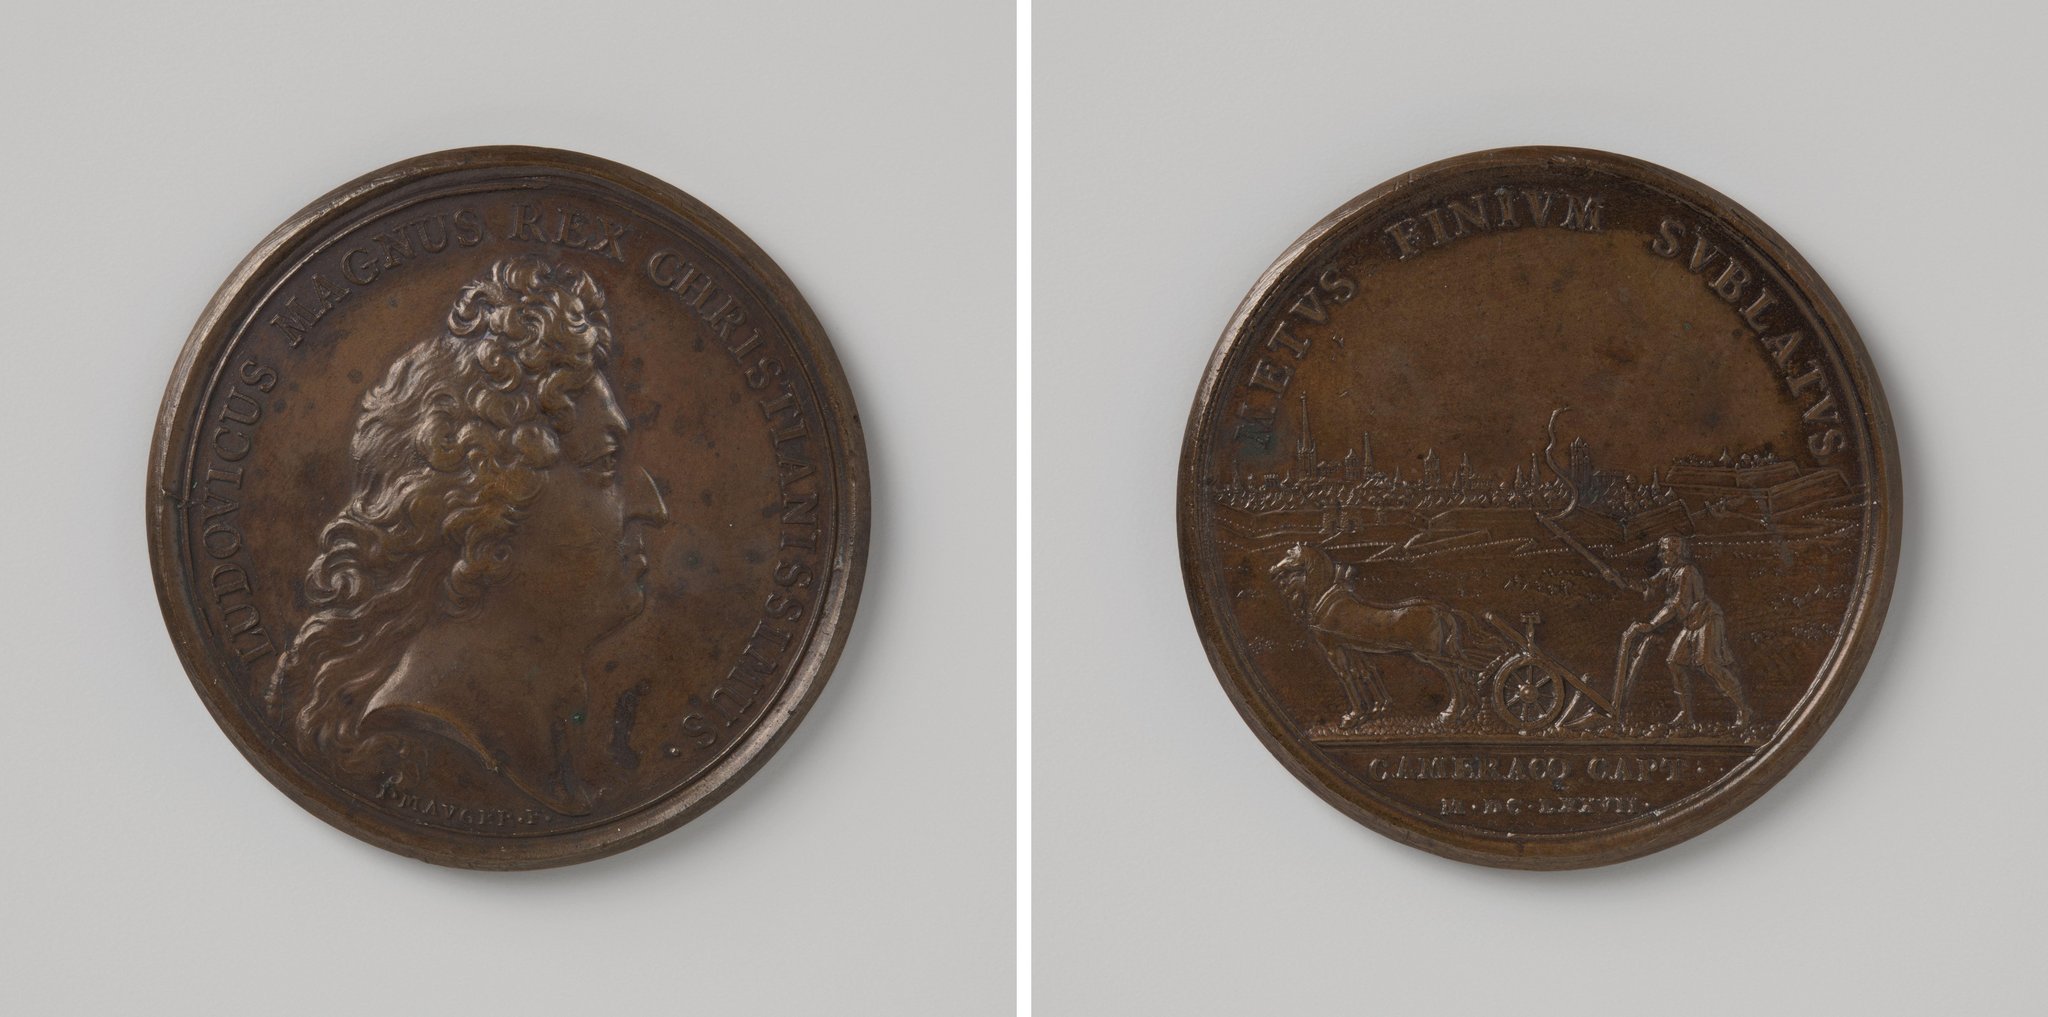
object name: history medal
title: Inname van Kamerijk door de Fransen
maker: jean mauger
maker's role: medailleur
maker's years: 1648-1722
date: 1699-1703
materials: bronze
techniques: striking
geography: paris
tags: lodewijk xiv (koning van frankrijk)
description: Bronzen penning. Voorzijde: borststuk man binnen omschrift. Keerzijde: boer ploegt akkers, op achtergrond gezicht op stad binnen omschrift; afsnede: opschrift